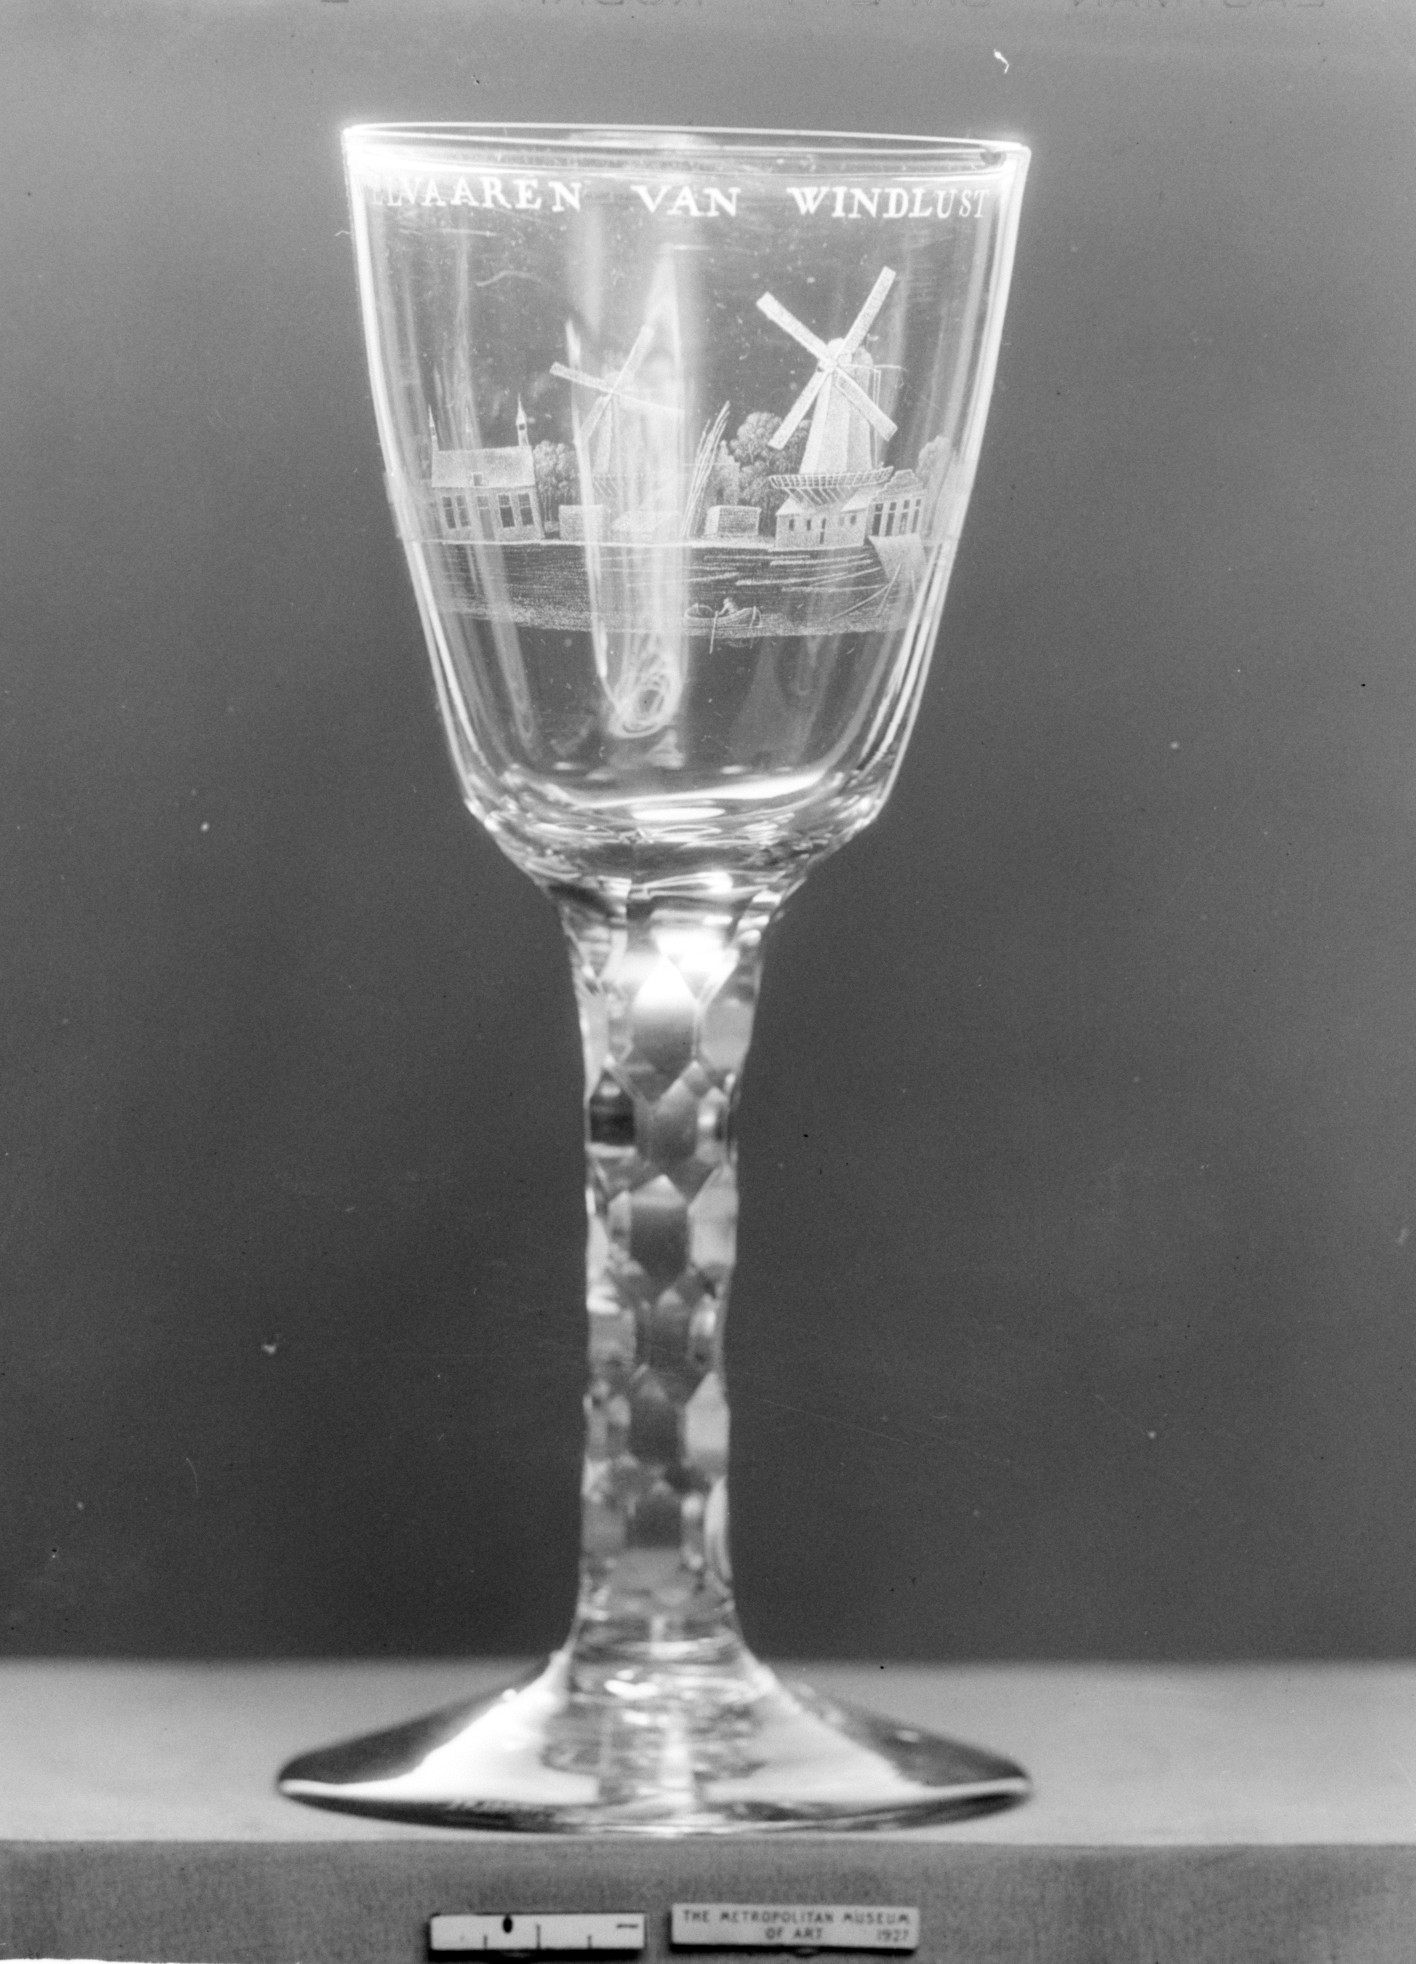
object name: wineglass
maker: david wolff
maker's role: engraver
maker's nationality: dutch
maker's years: 1732-1798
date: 1767-1800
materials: glass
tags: houses,windmills